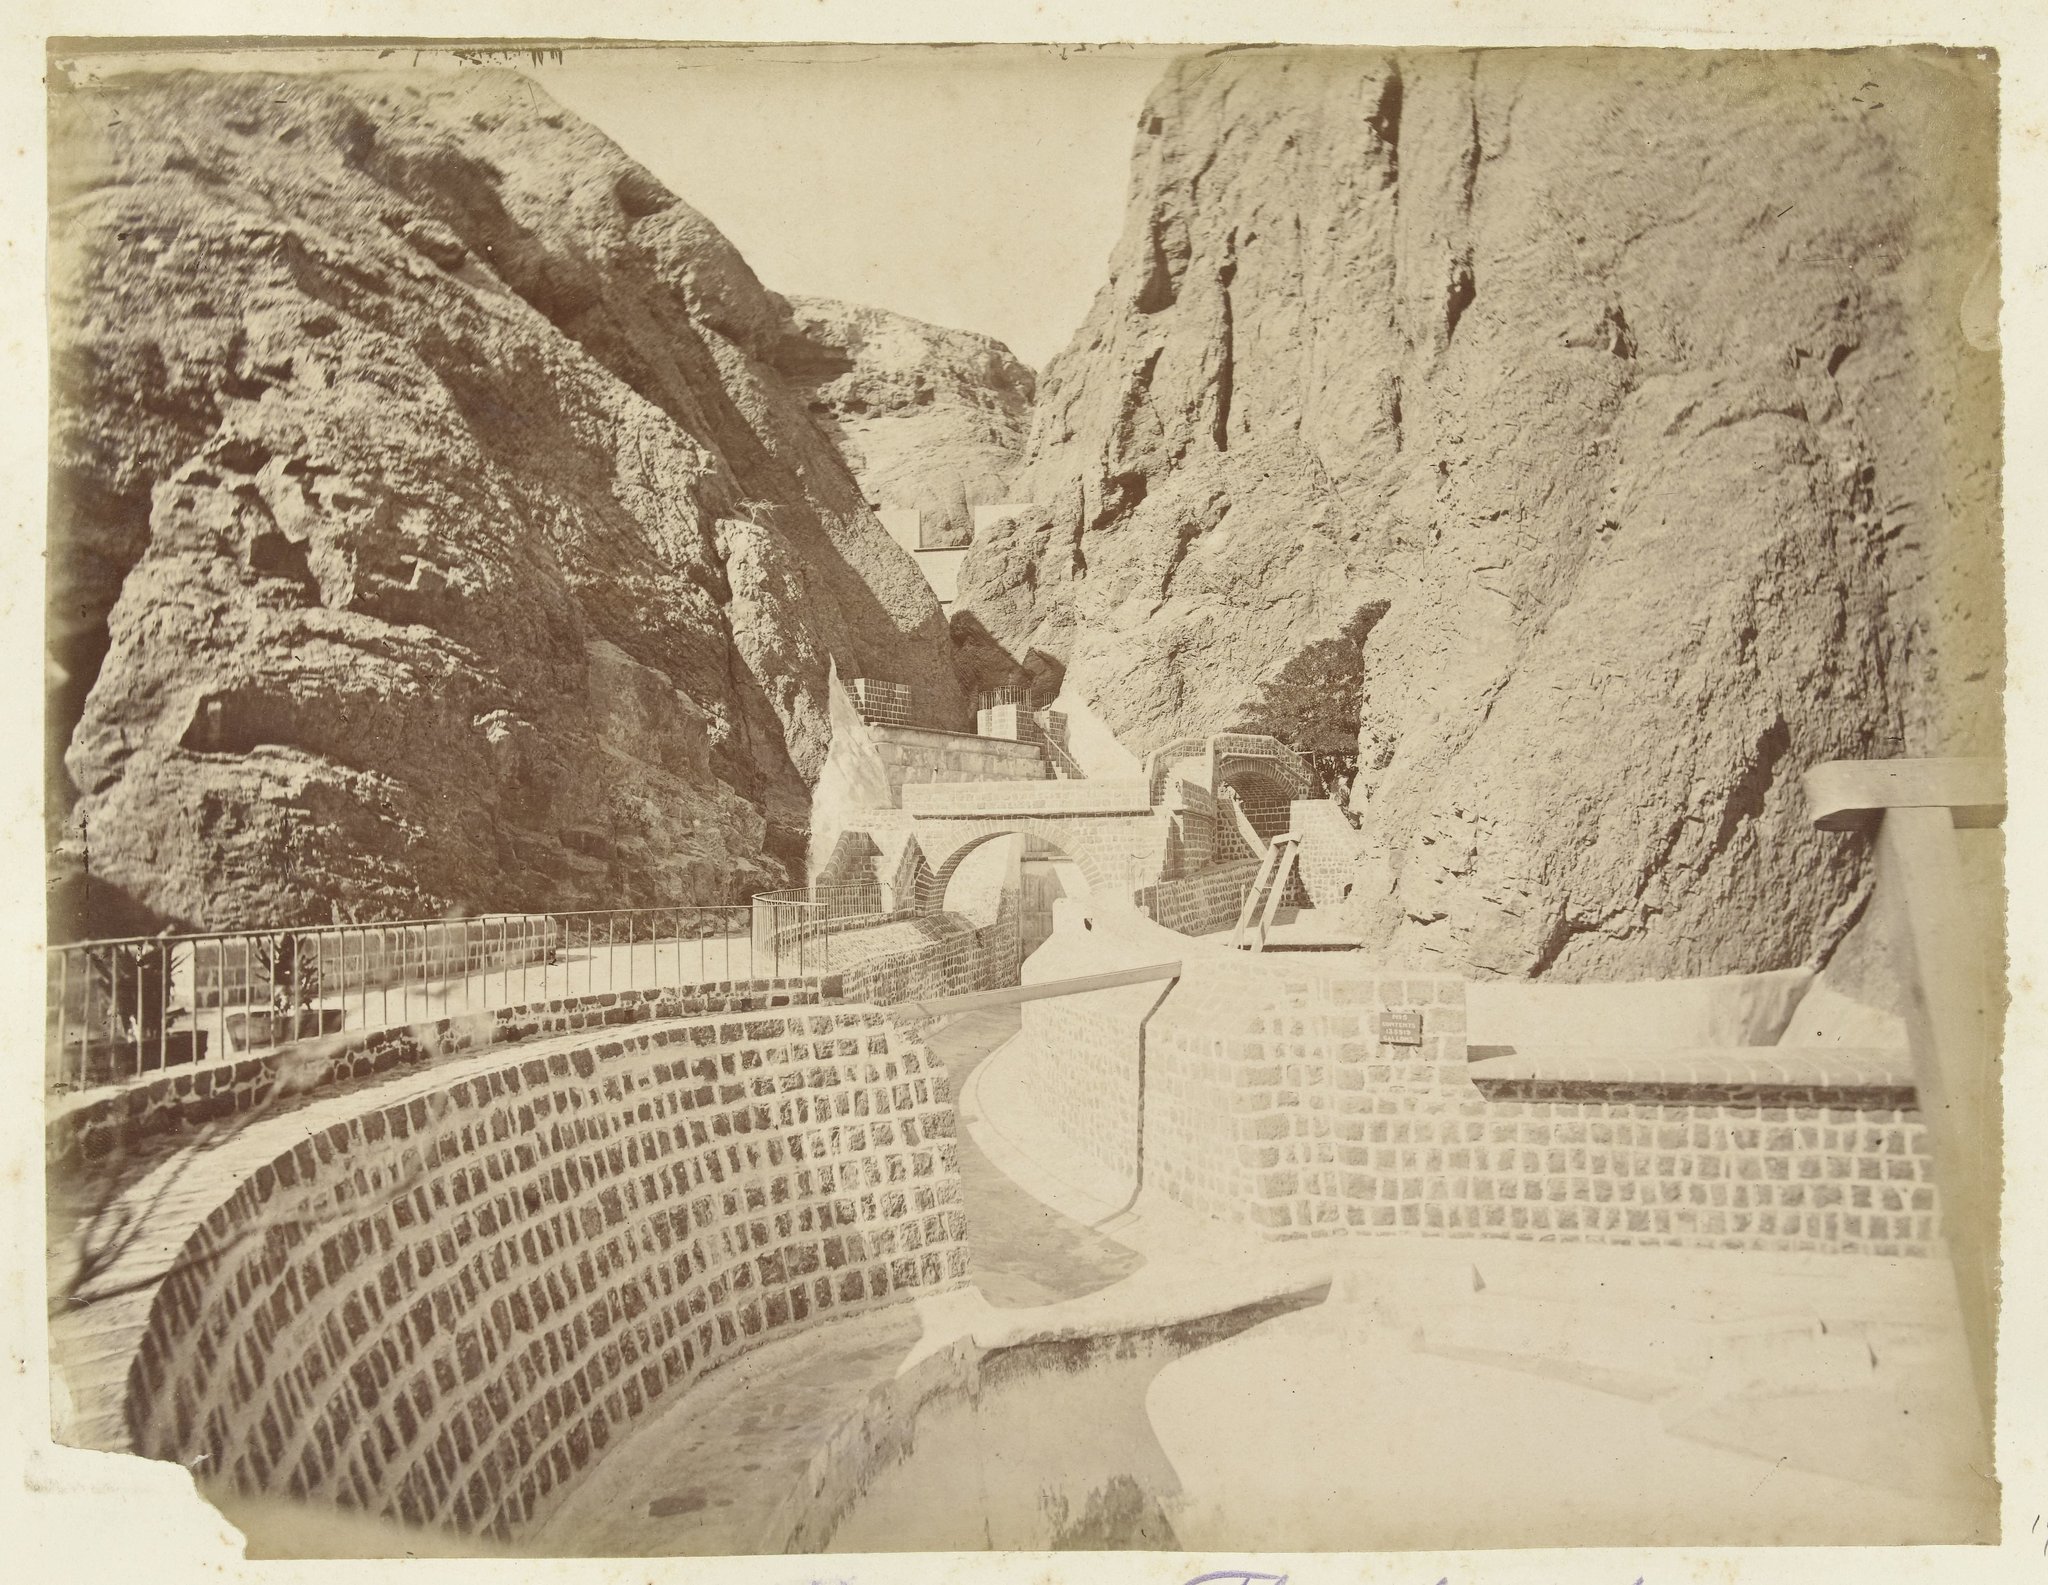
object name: photograph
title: Waterbassins in het bergachtige landschap in Aden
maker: Anonymous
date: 1890-1910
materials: cardboard, paper, photographic support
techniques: gelatin silver print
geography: aden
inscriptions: caption: ‘Aden waterworks. The tanks’